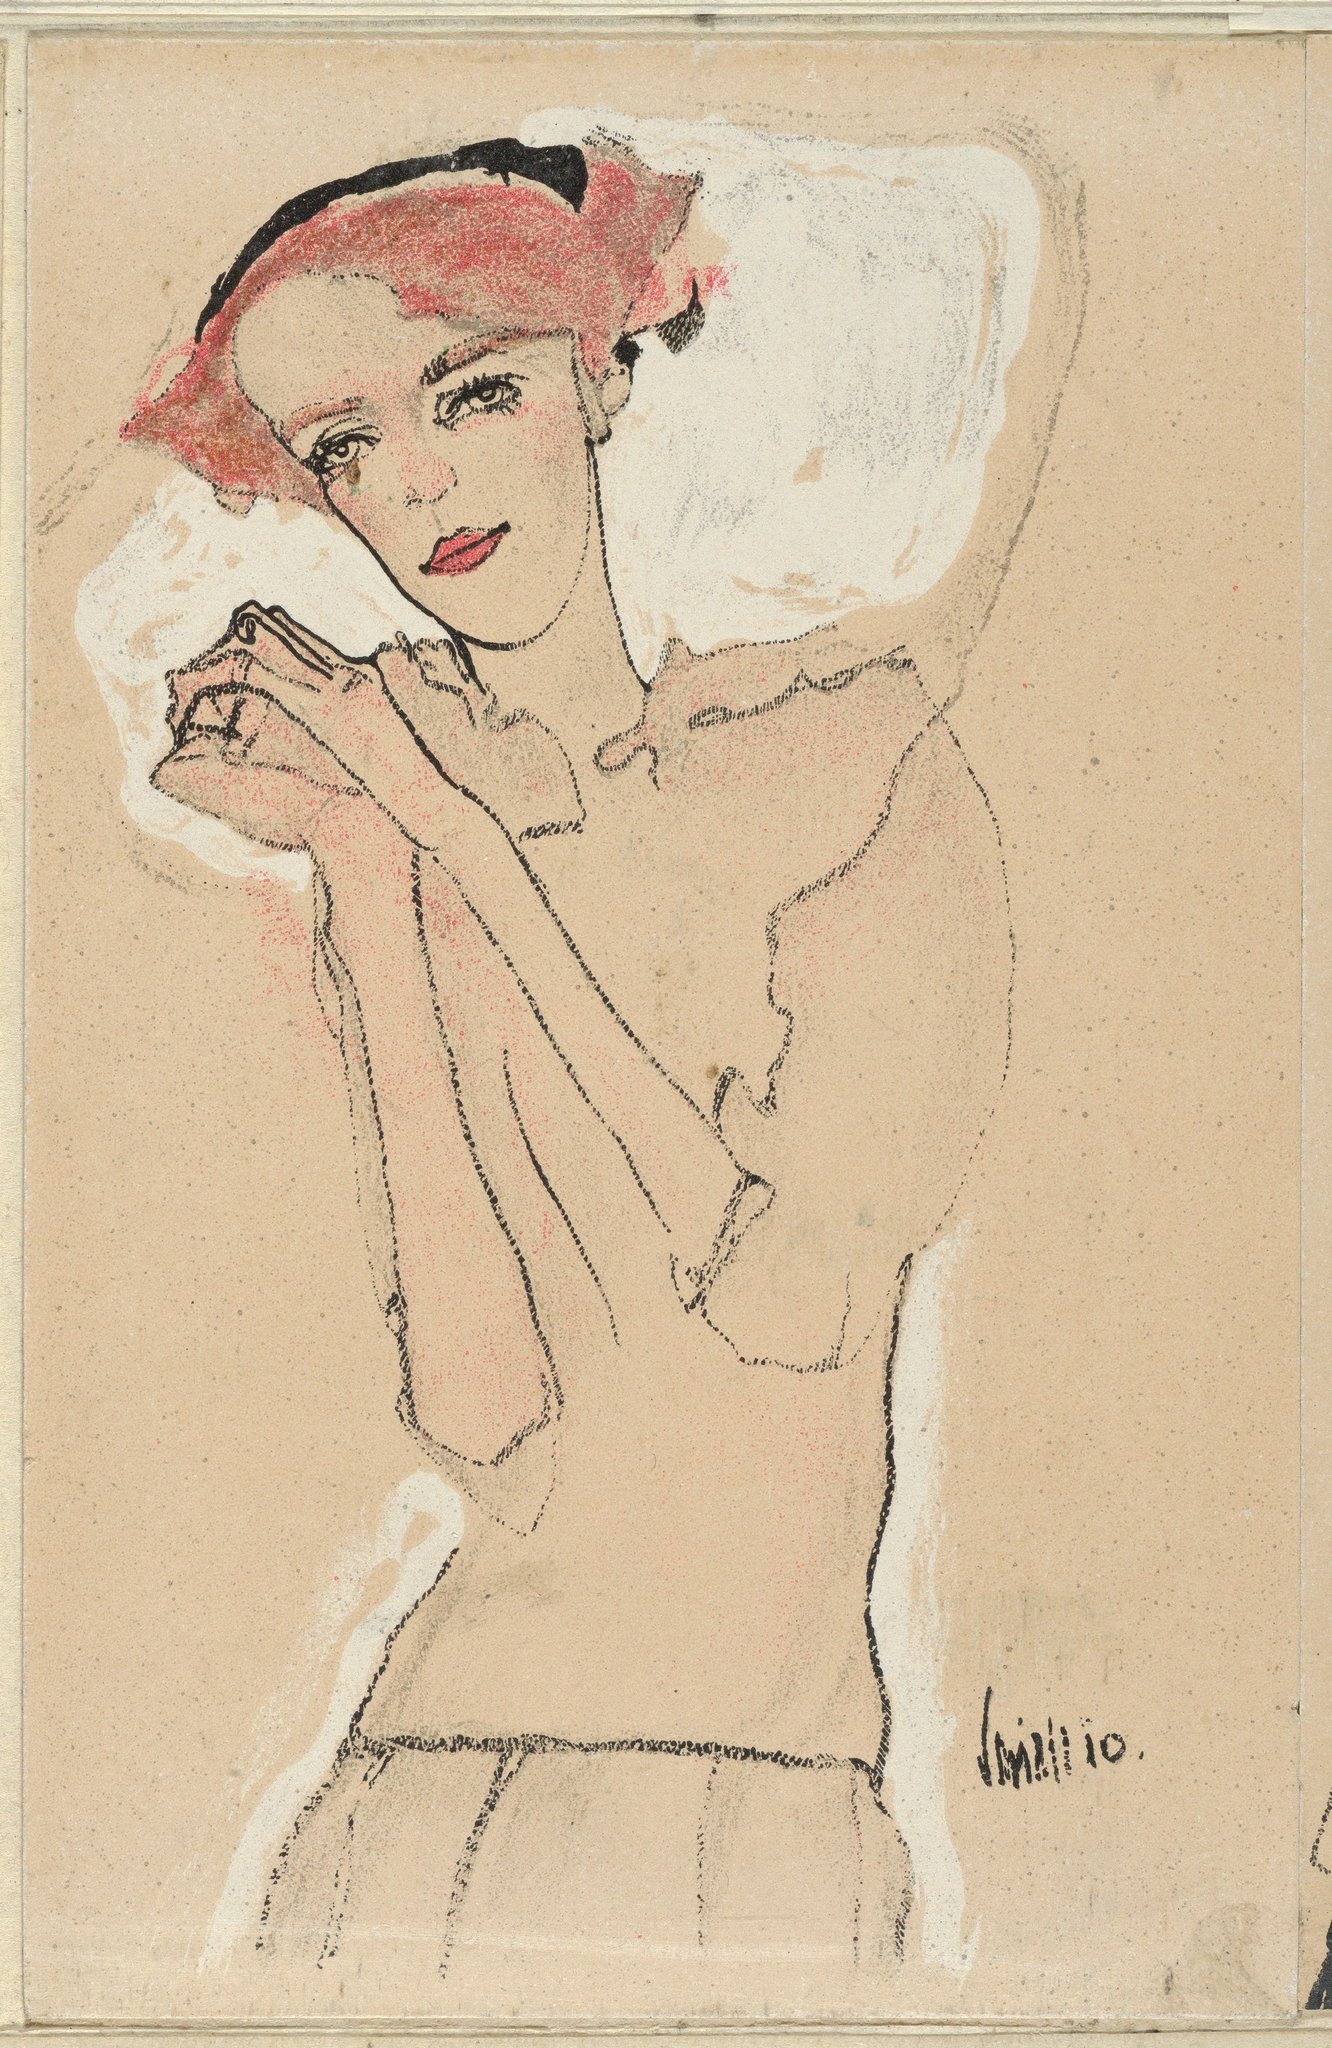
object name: print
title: Portrait of a Woman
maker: egon schiele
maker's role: artist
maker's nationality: austrian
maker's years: 1890-1918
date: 1910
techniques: lithograph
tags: portraits,women